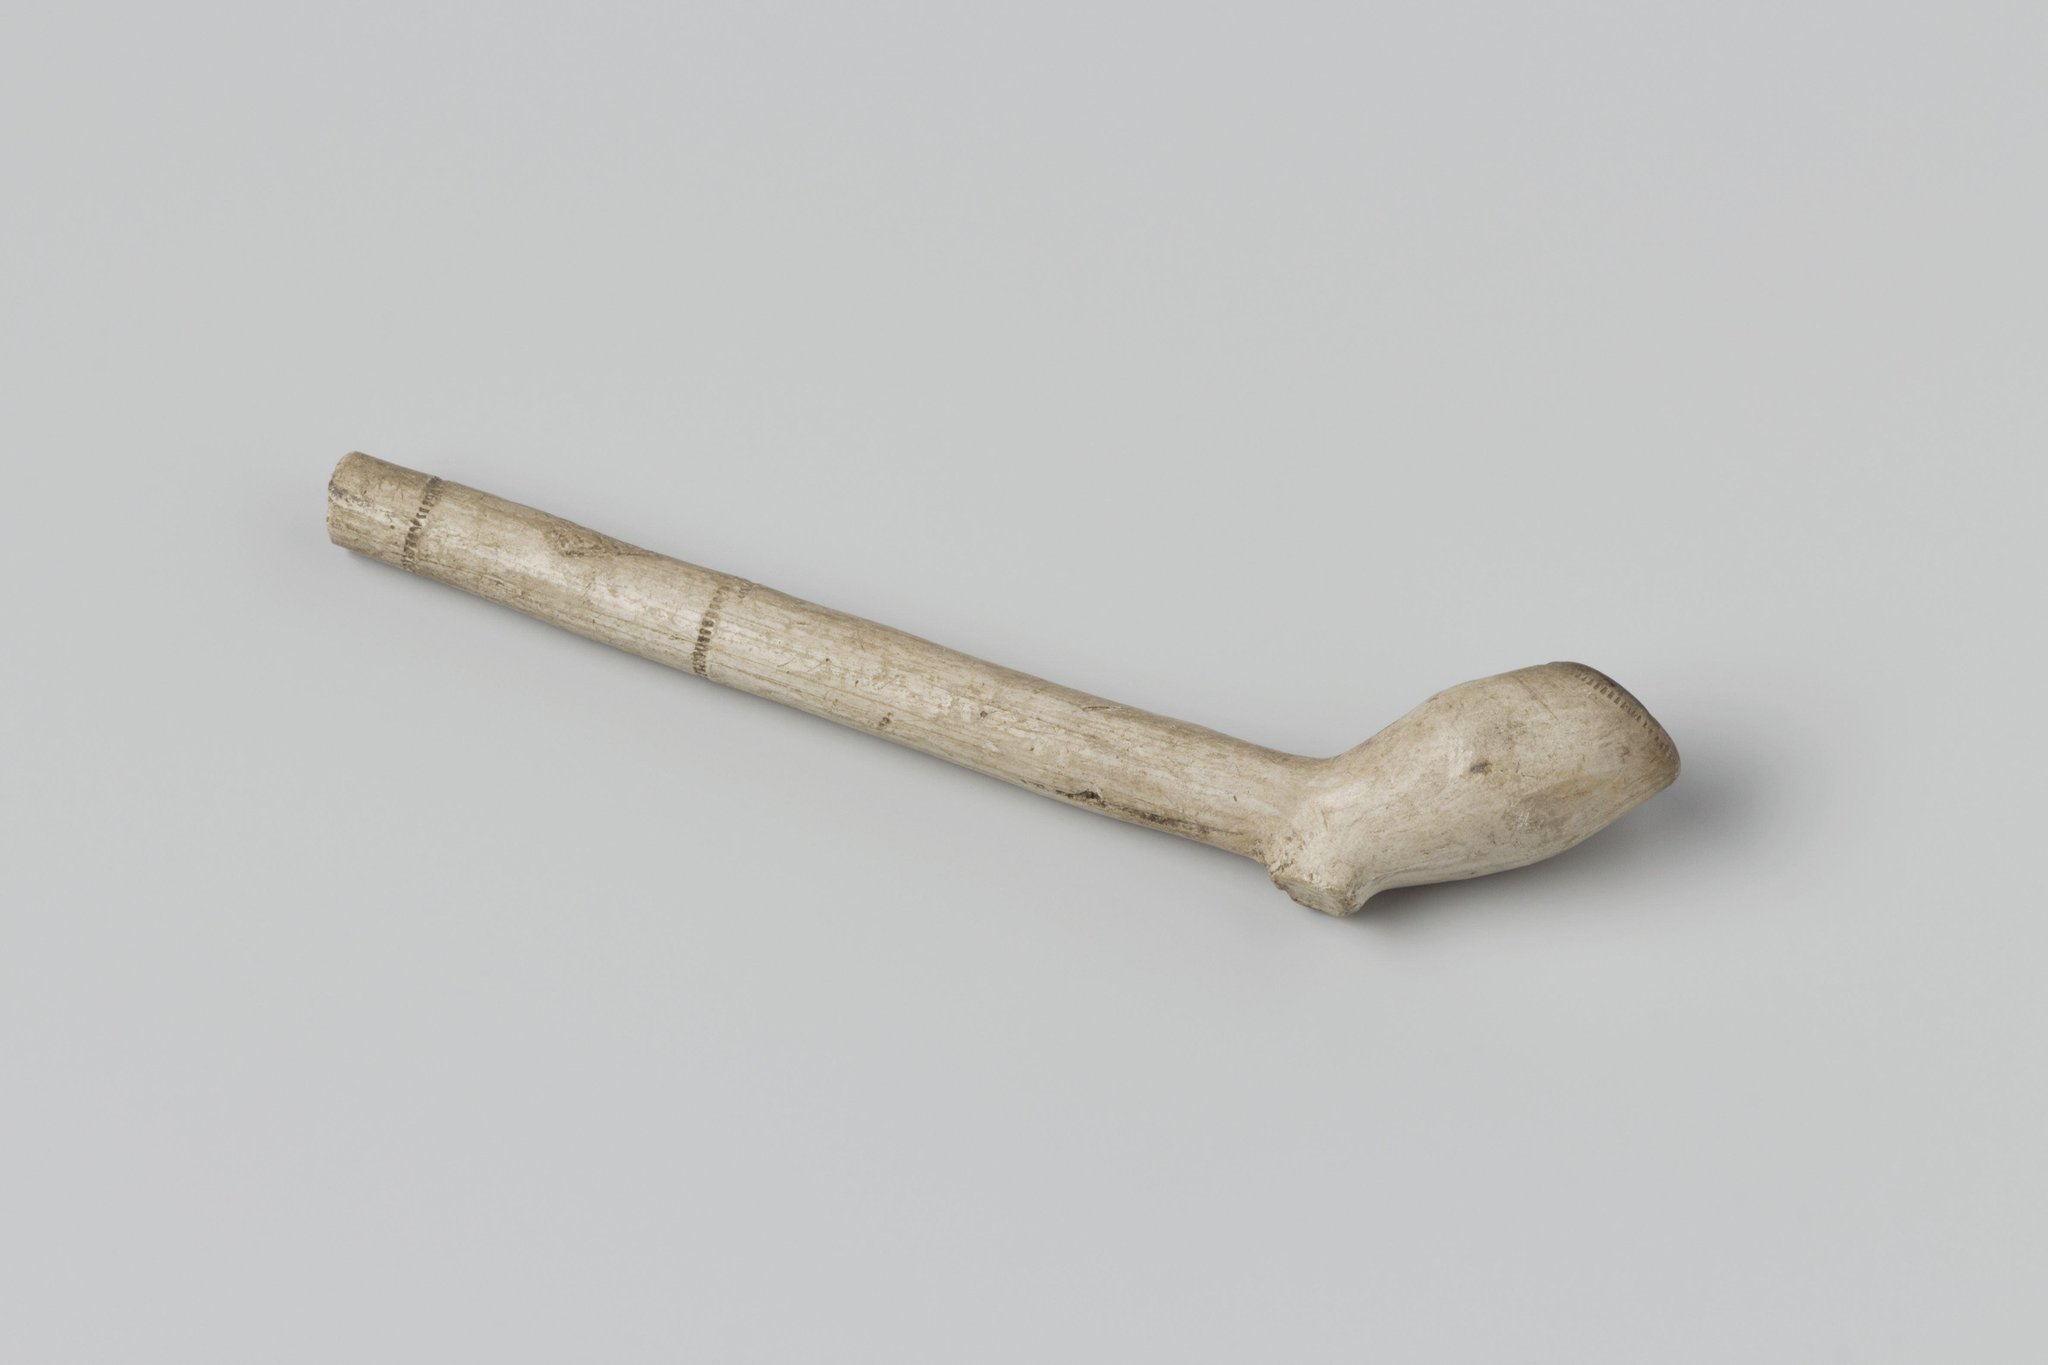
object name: fragment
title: Fragment van een tabakspijp.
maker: Anonymous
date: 1600-1699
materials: clay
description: Een fragment van een kleine witte tabakspijp, waarop H.